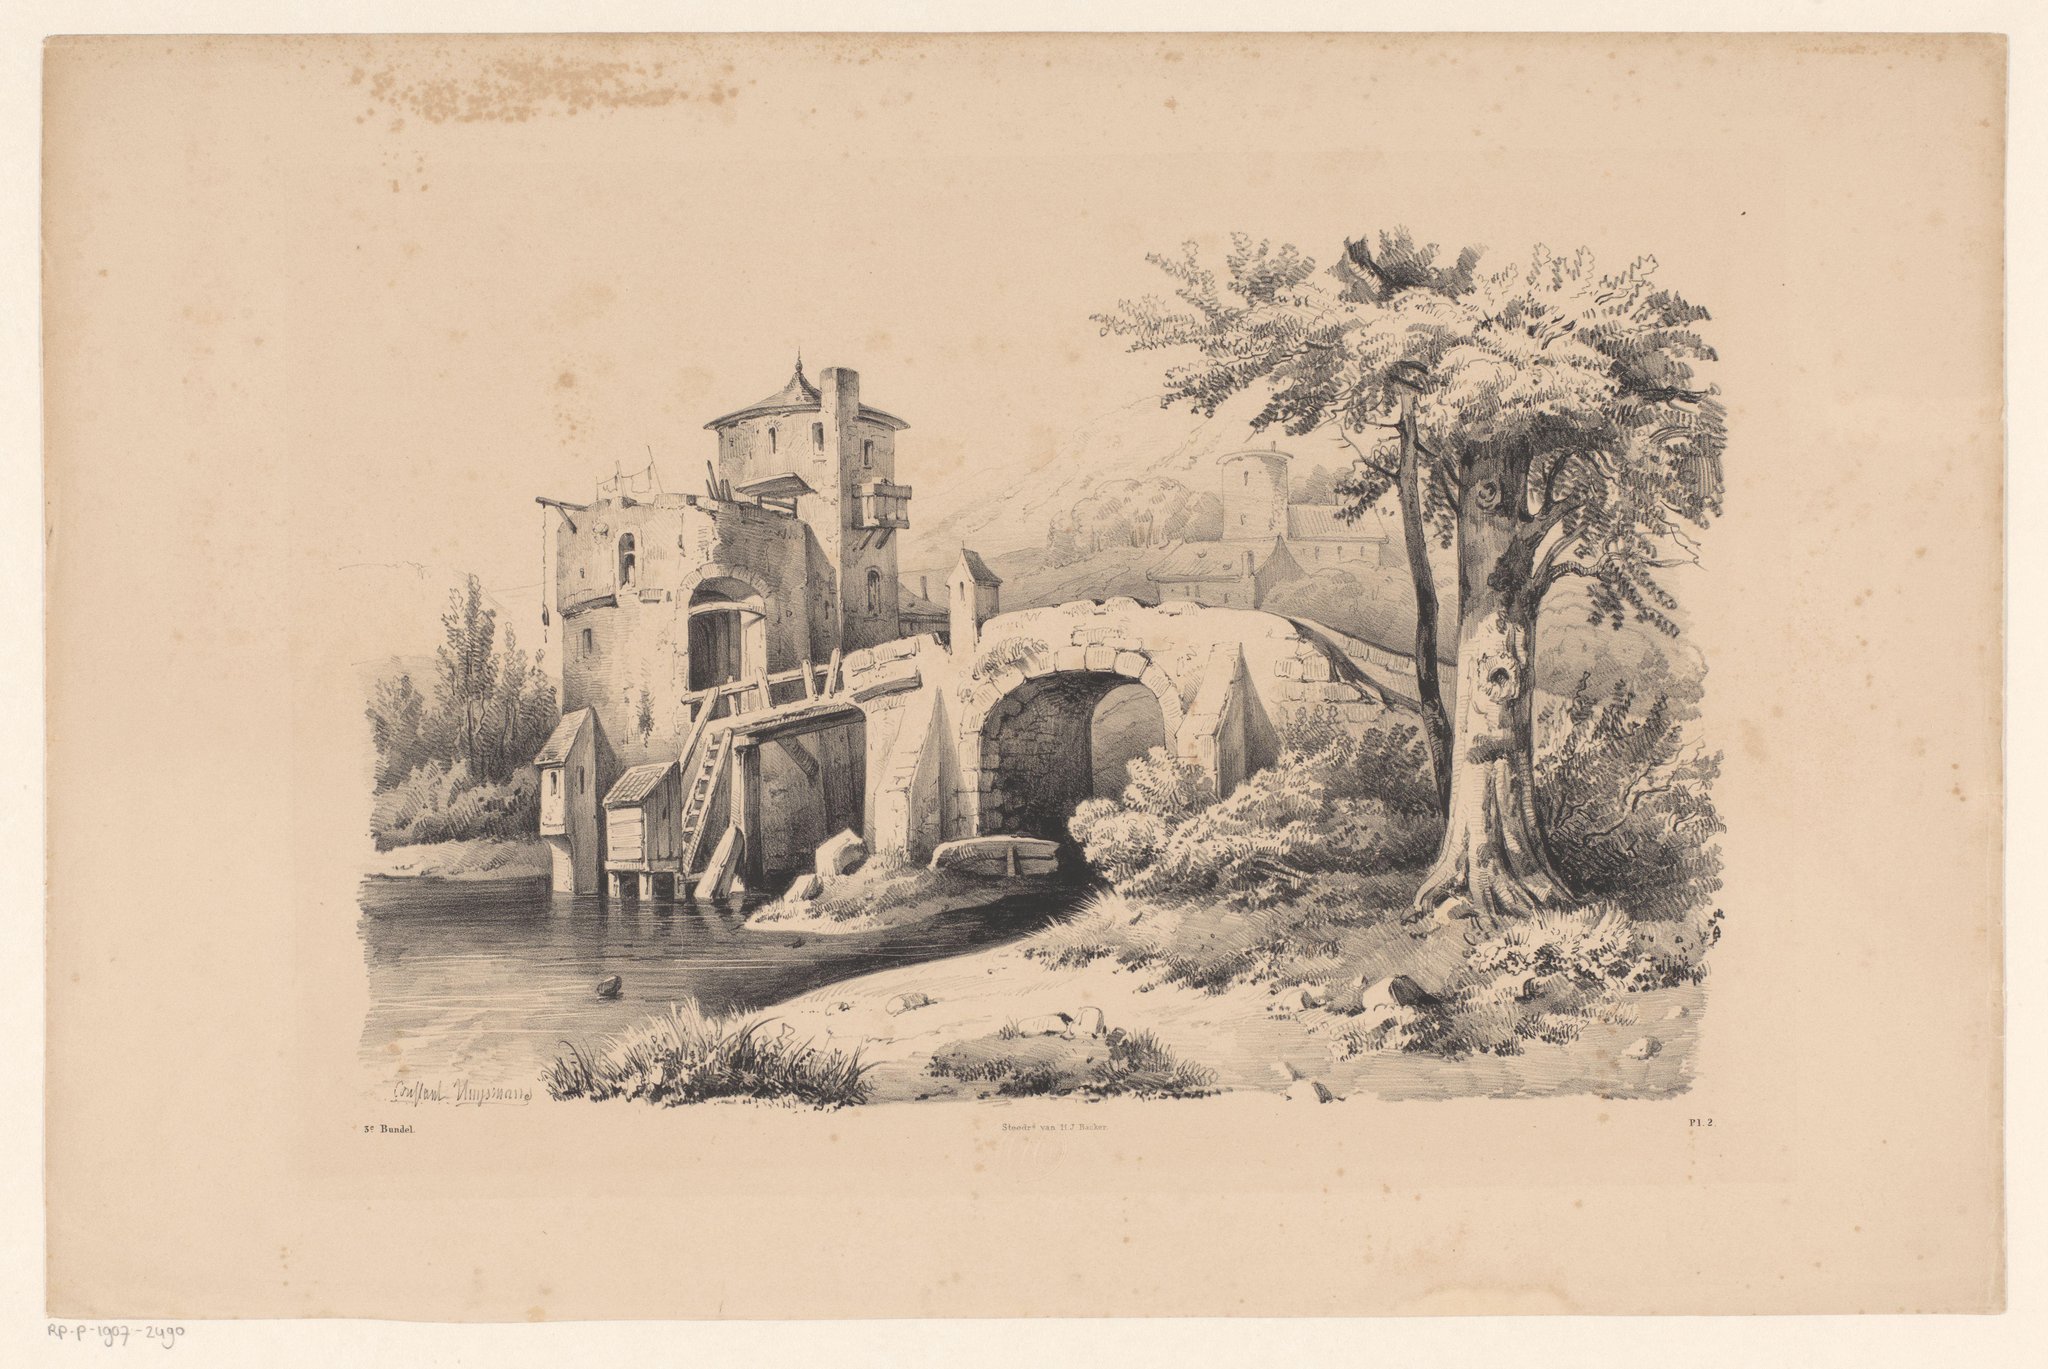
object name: print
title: Landschap met brug en vestingtoren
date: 1838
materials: paper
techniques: lithograph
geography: dordrecht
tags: city-view, and landscape with man-made constructions, towers ~ fortified city, landscape with bridge, viaduct or aqueduct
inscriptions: collector's mark: Lugt 2228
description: Deze prent maakt deel uit van een serie getiteld 'Het Landschap' door Constantinus Cornelis Huysmans. Deze serie werd door hem gebruikt als lesmateriaal op de Koninklijke Militaire Academie te Breda. Hij was docent handtekenen van 1837 tot 1866. Zie: W. van Giersbergen.